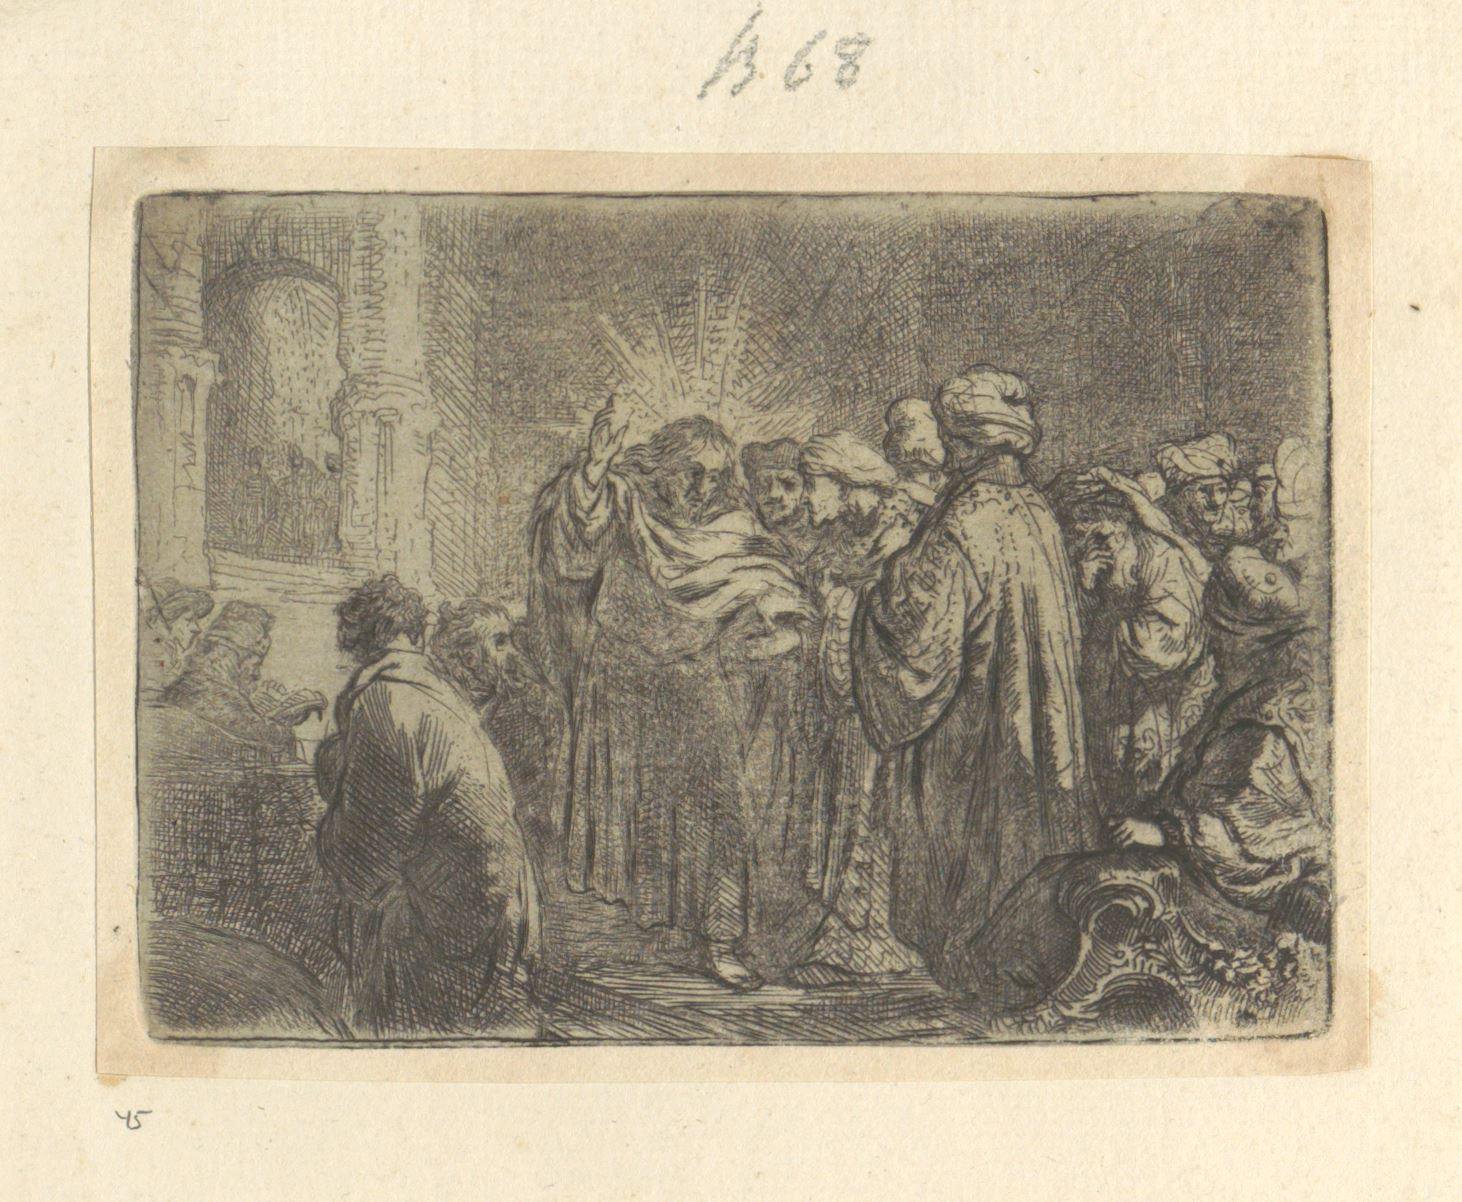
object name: print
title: Recueil de quatre-vingt-cinq estampes originales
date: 1633-1637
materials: paper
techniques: drypoint, etching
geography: paris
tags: christ discussing the temple tribute with the apostles